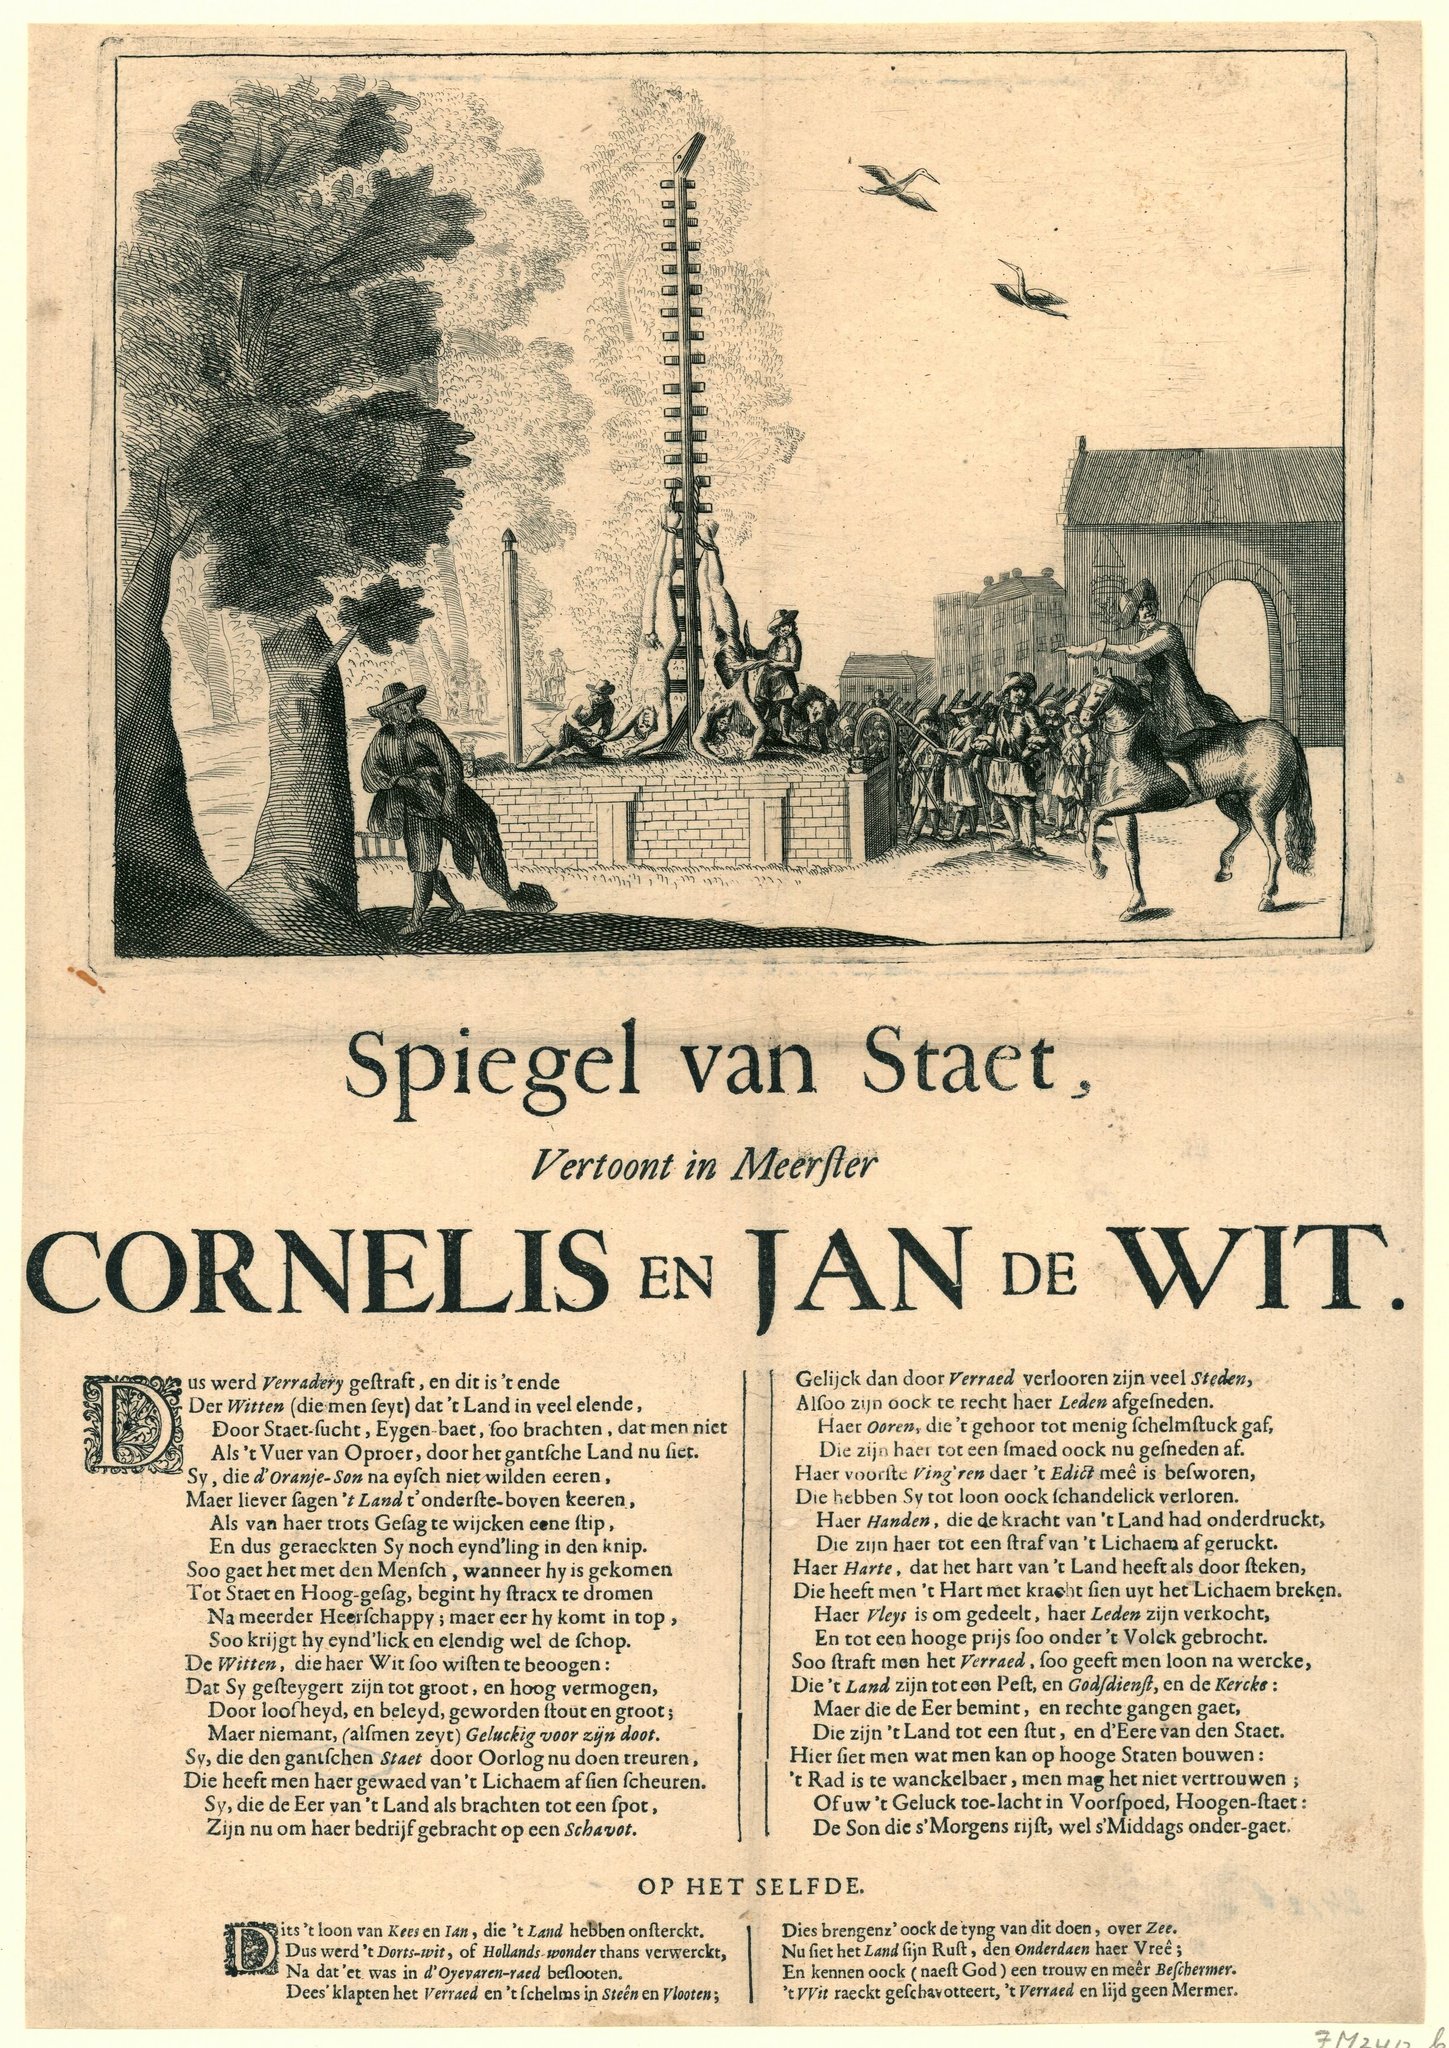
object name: print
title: Verminking van de lichamen van de gebroeders de Witt, 1672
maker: Anonymous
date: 1672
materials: paper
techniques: engraving, etching, letterpress printing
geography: northern netherlands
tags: cornelis de witt, politician, johan de witt, mutilation of the corpse, lynching, attempt, political murder, violent death, being killed; being mishandled and maltreated; seeking death (+ death by lynching), the hague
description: Eenvoudige voorstelling van de verminking van de lichamen van de gebroeders Johan en Cornelis de Witt, 20 augustus 1672. Rechts een ruiter; op de voorgrond een man met een kledingstuk van een van de slachtoffers. Deze staat van de prent is vóór de figuren in de poort achter de ruiter, de man voor het schavot en de twee jongens op de wip. Onder de voorstelling twee verzen waarin de moorden worden gerechtvaardigd.